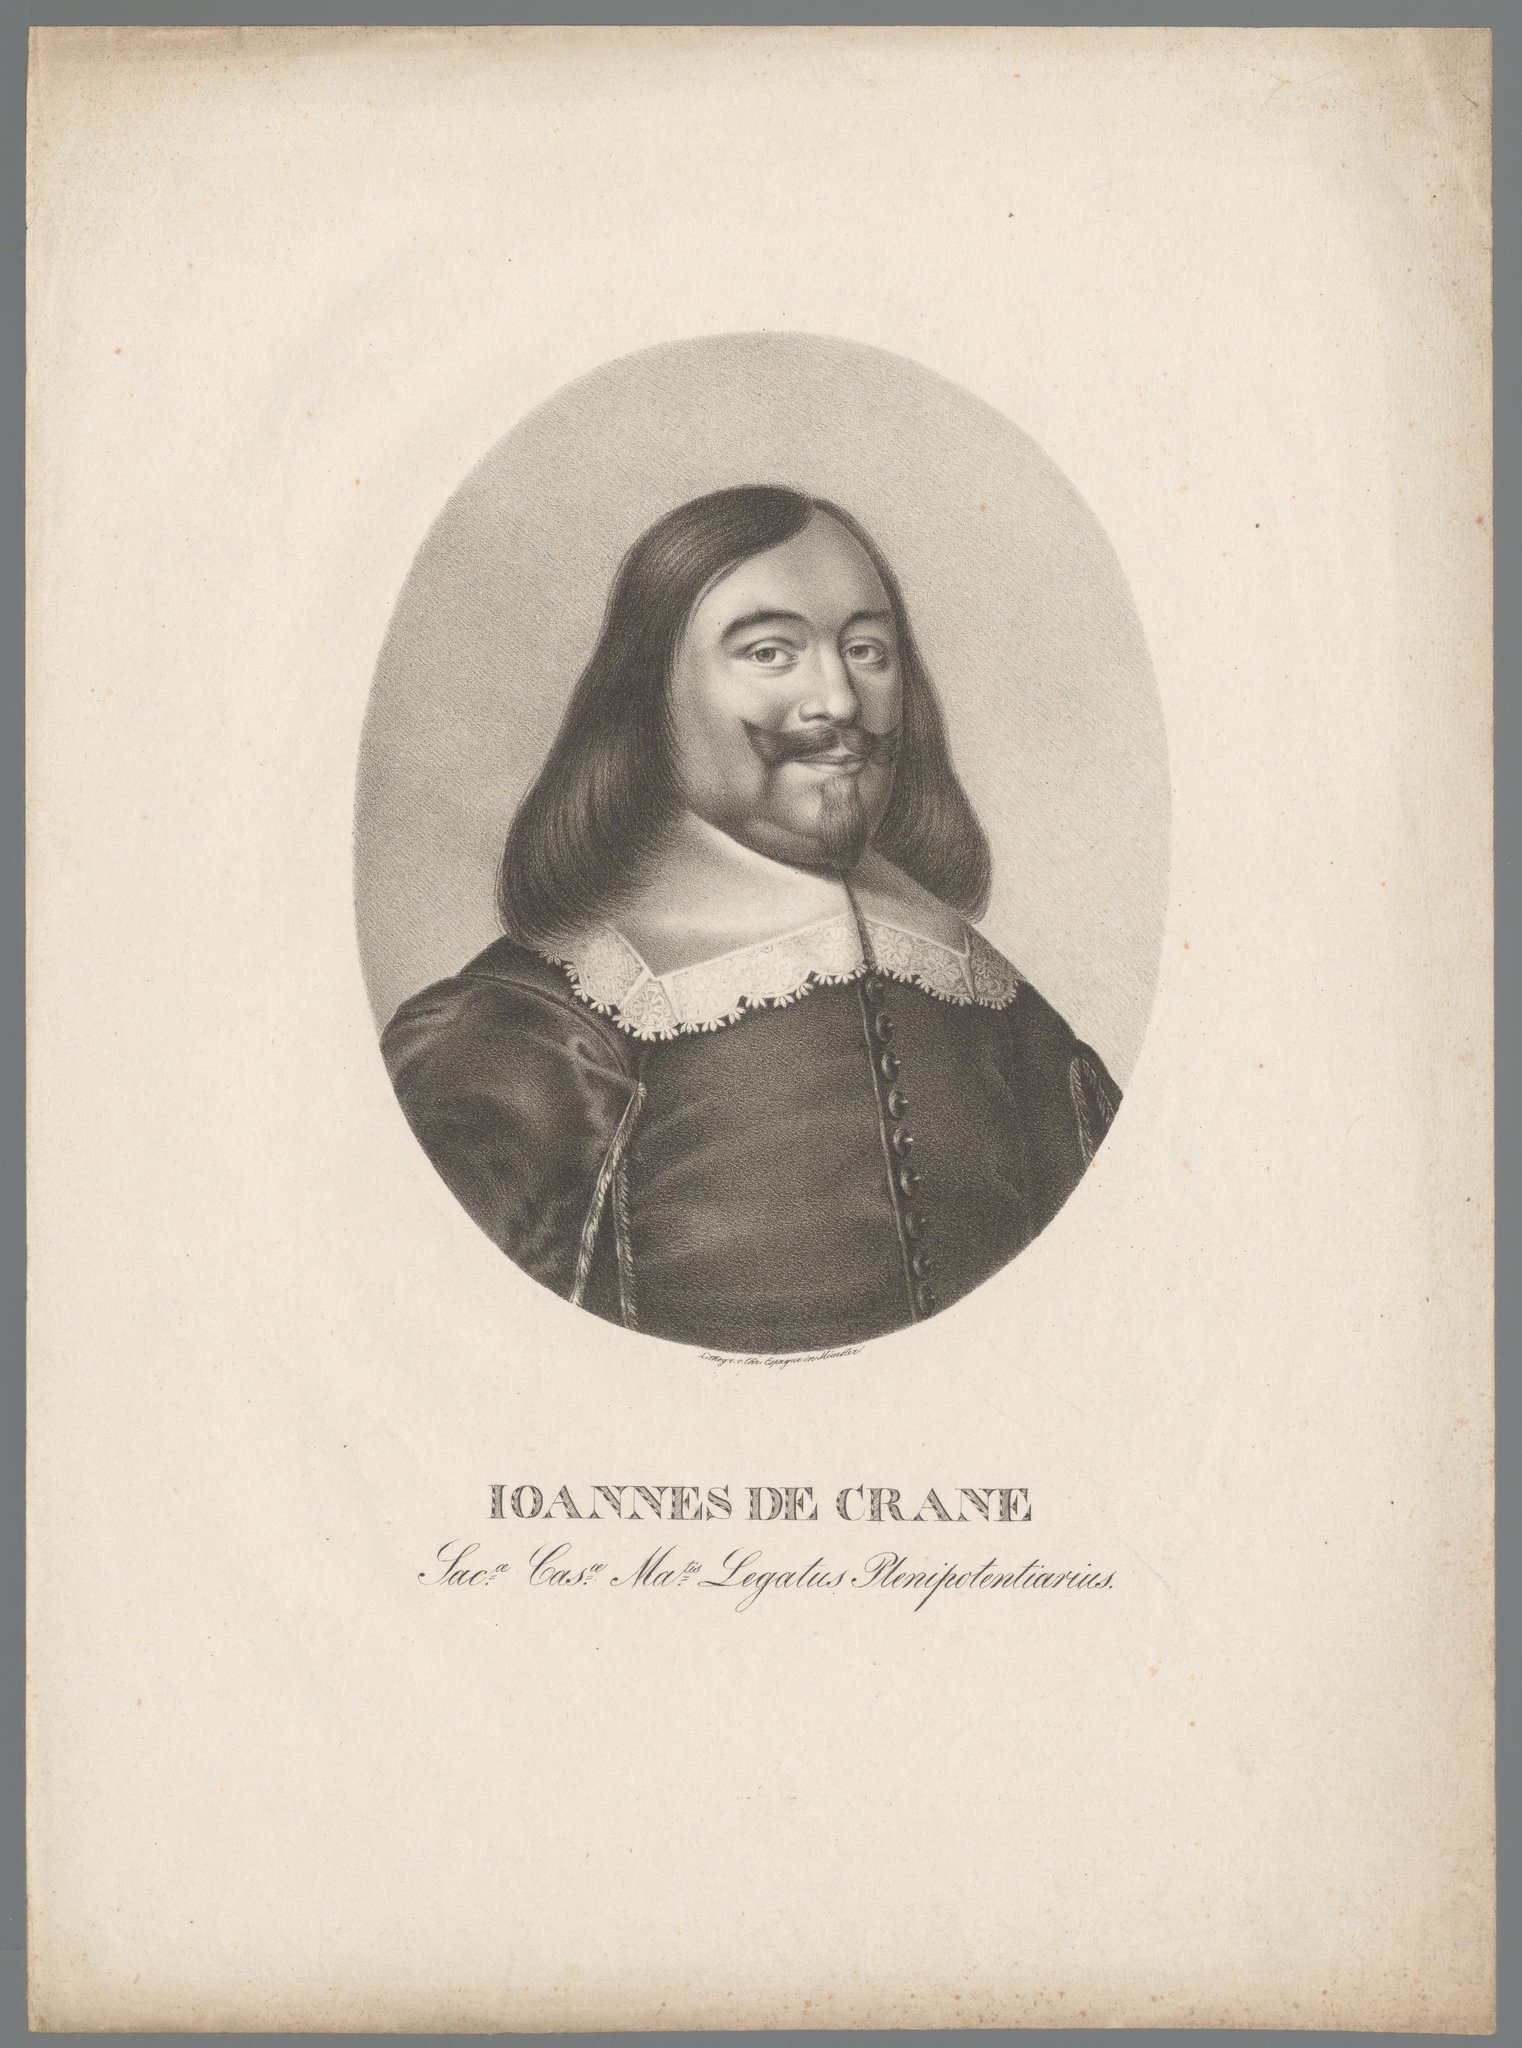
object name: print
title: Portret van Johann Crane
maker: christian espagne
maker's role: print maker, printer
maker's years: 1794-1838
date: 1824-1827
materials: paper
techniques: lithograph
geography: munster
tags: adult man, historical persons, beard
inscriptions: collector's mark: Lugt 2228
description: Prent uit: Bildnisse der beim westfälischen Friedensschluß zu Münster und Osnabrück versammelt gewesenen Gesandten. Münster: Christian Espagne, [1824-1827]. Deze publicatie bevat een onbekend aantal lithografieën, die in afleveringen verschenen als illustratie bij de tekst.